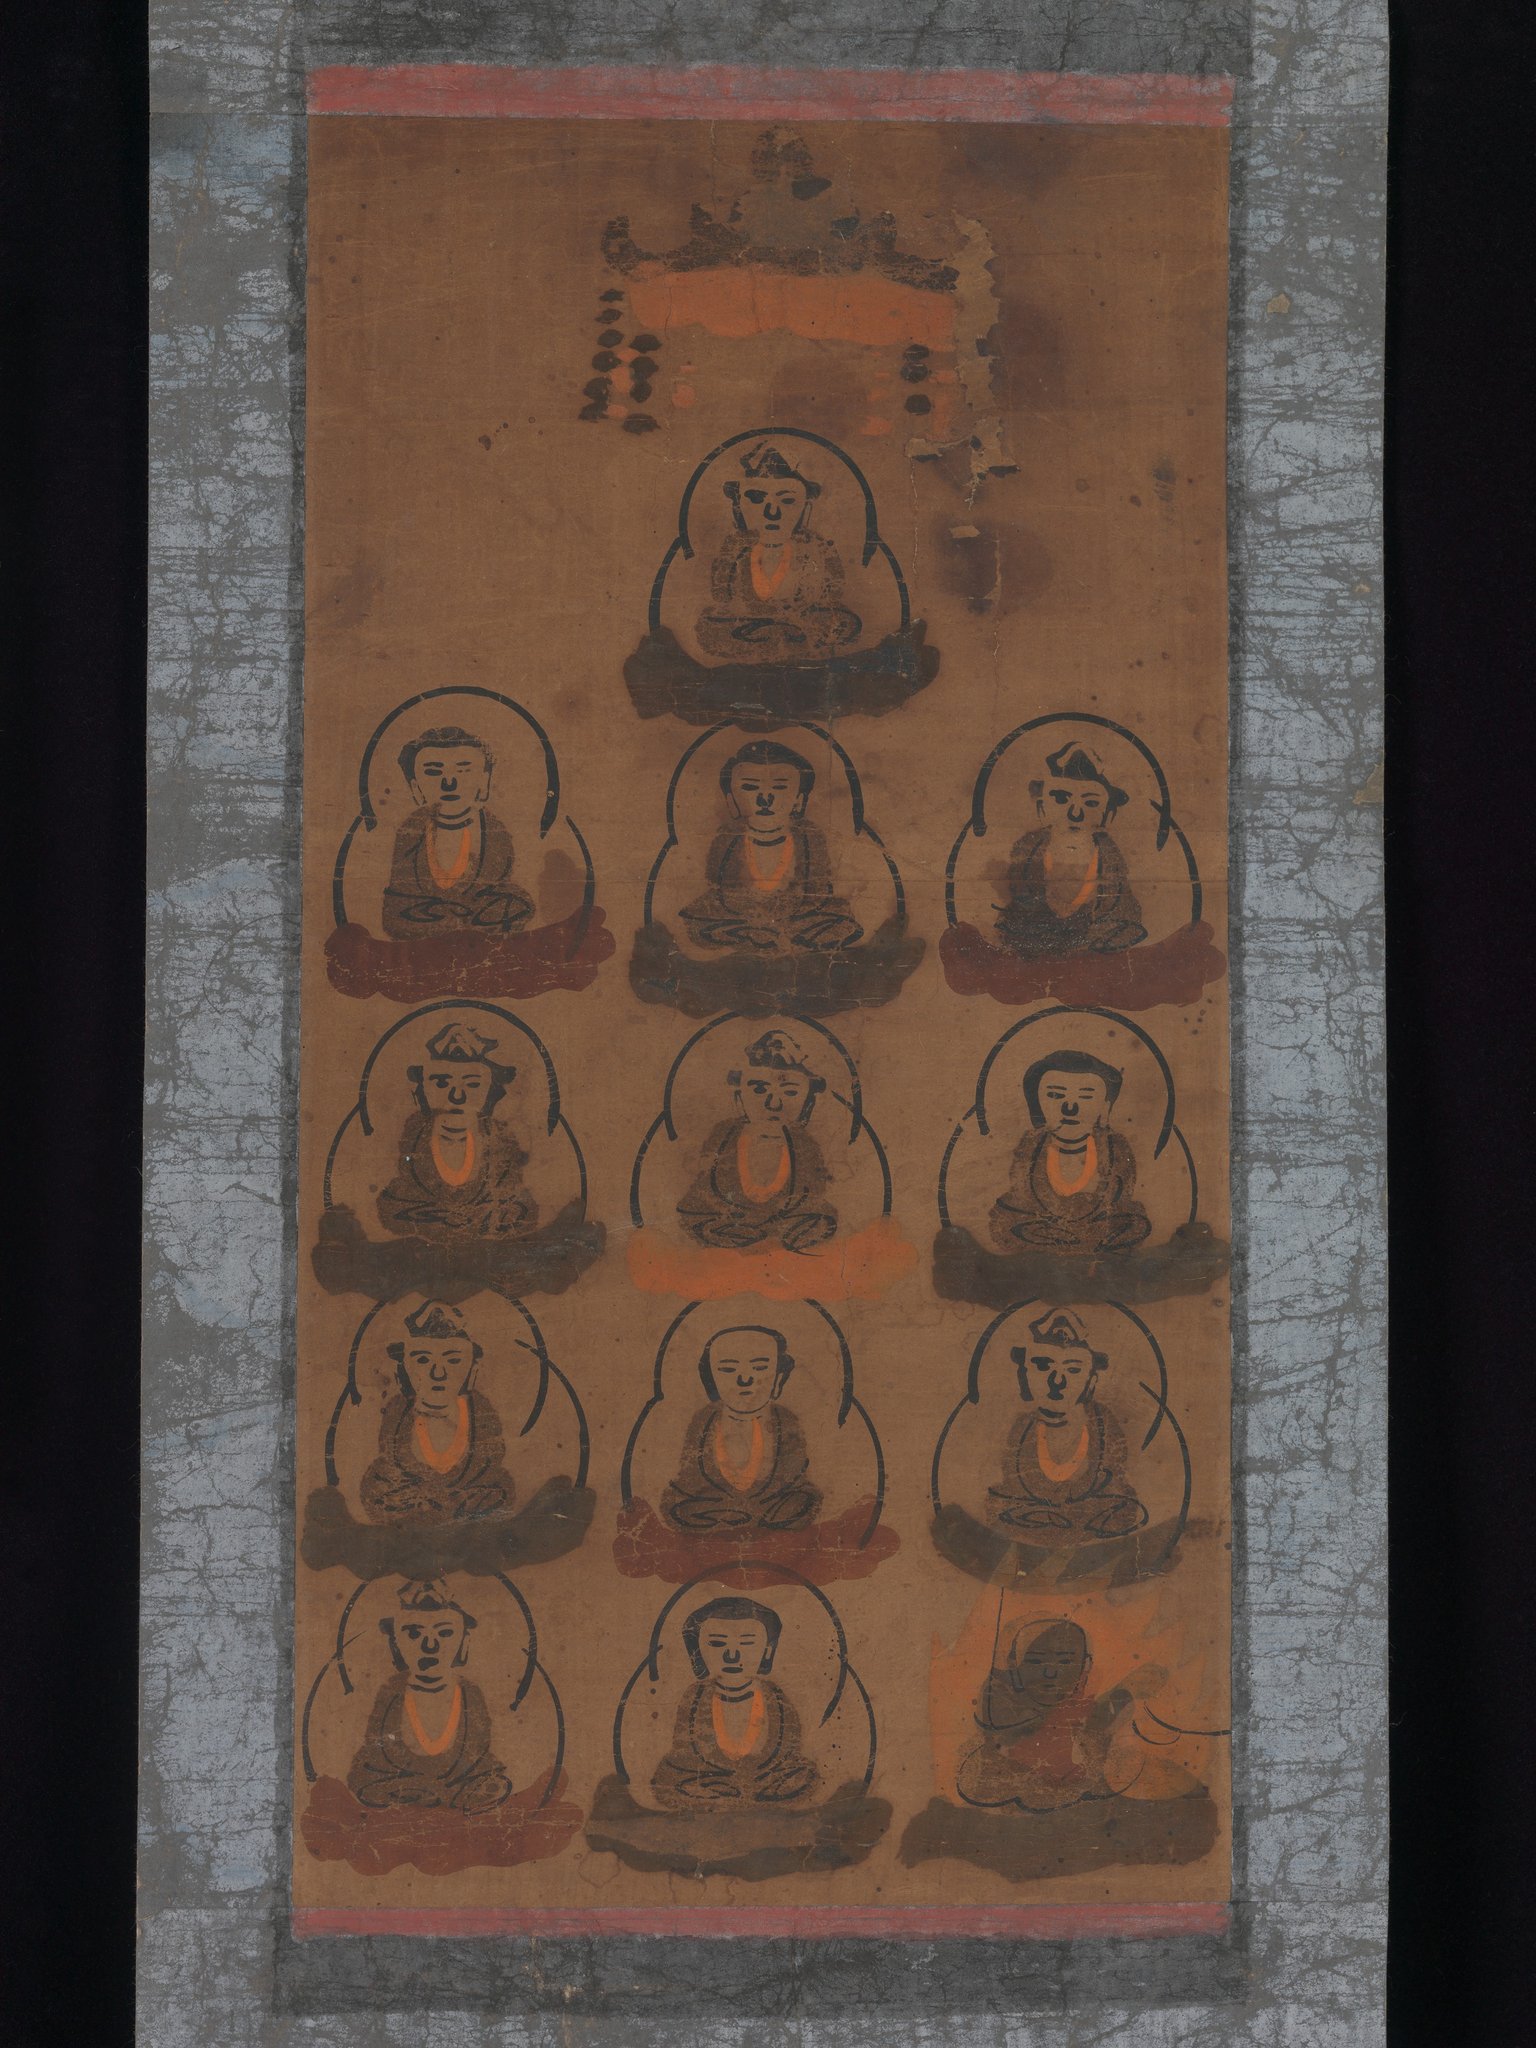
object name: hanging scroll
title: Ōtsu-e of Thirteen Buddhist Deities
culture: japanese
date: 1601-1700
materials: ink, paper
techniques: woodblock print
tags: buddhism,deities